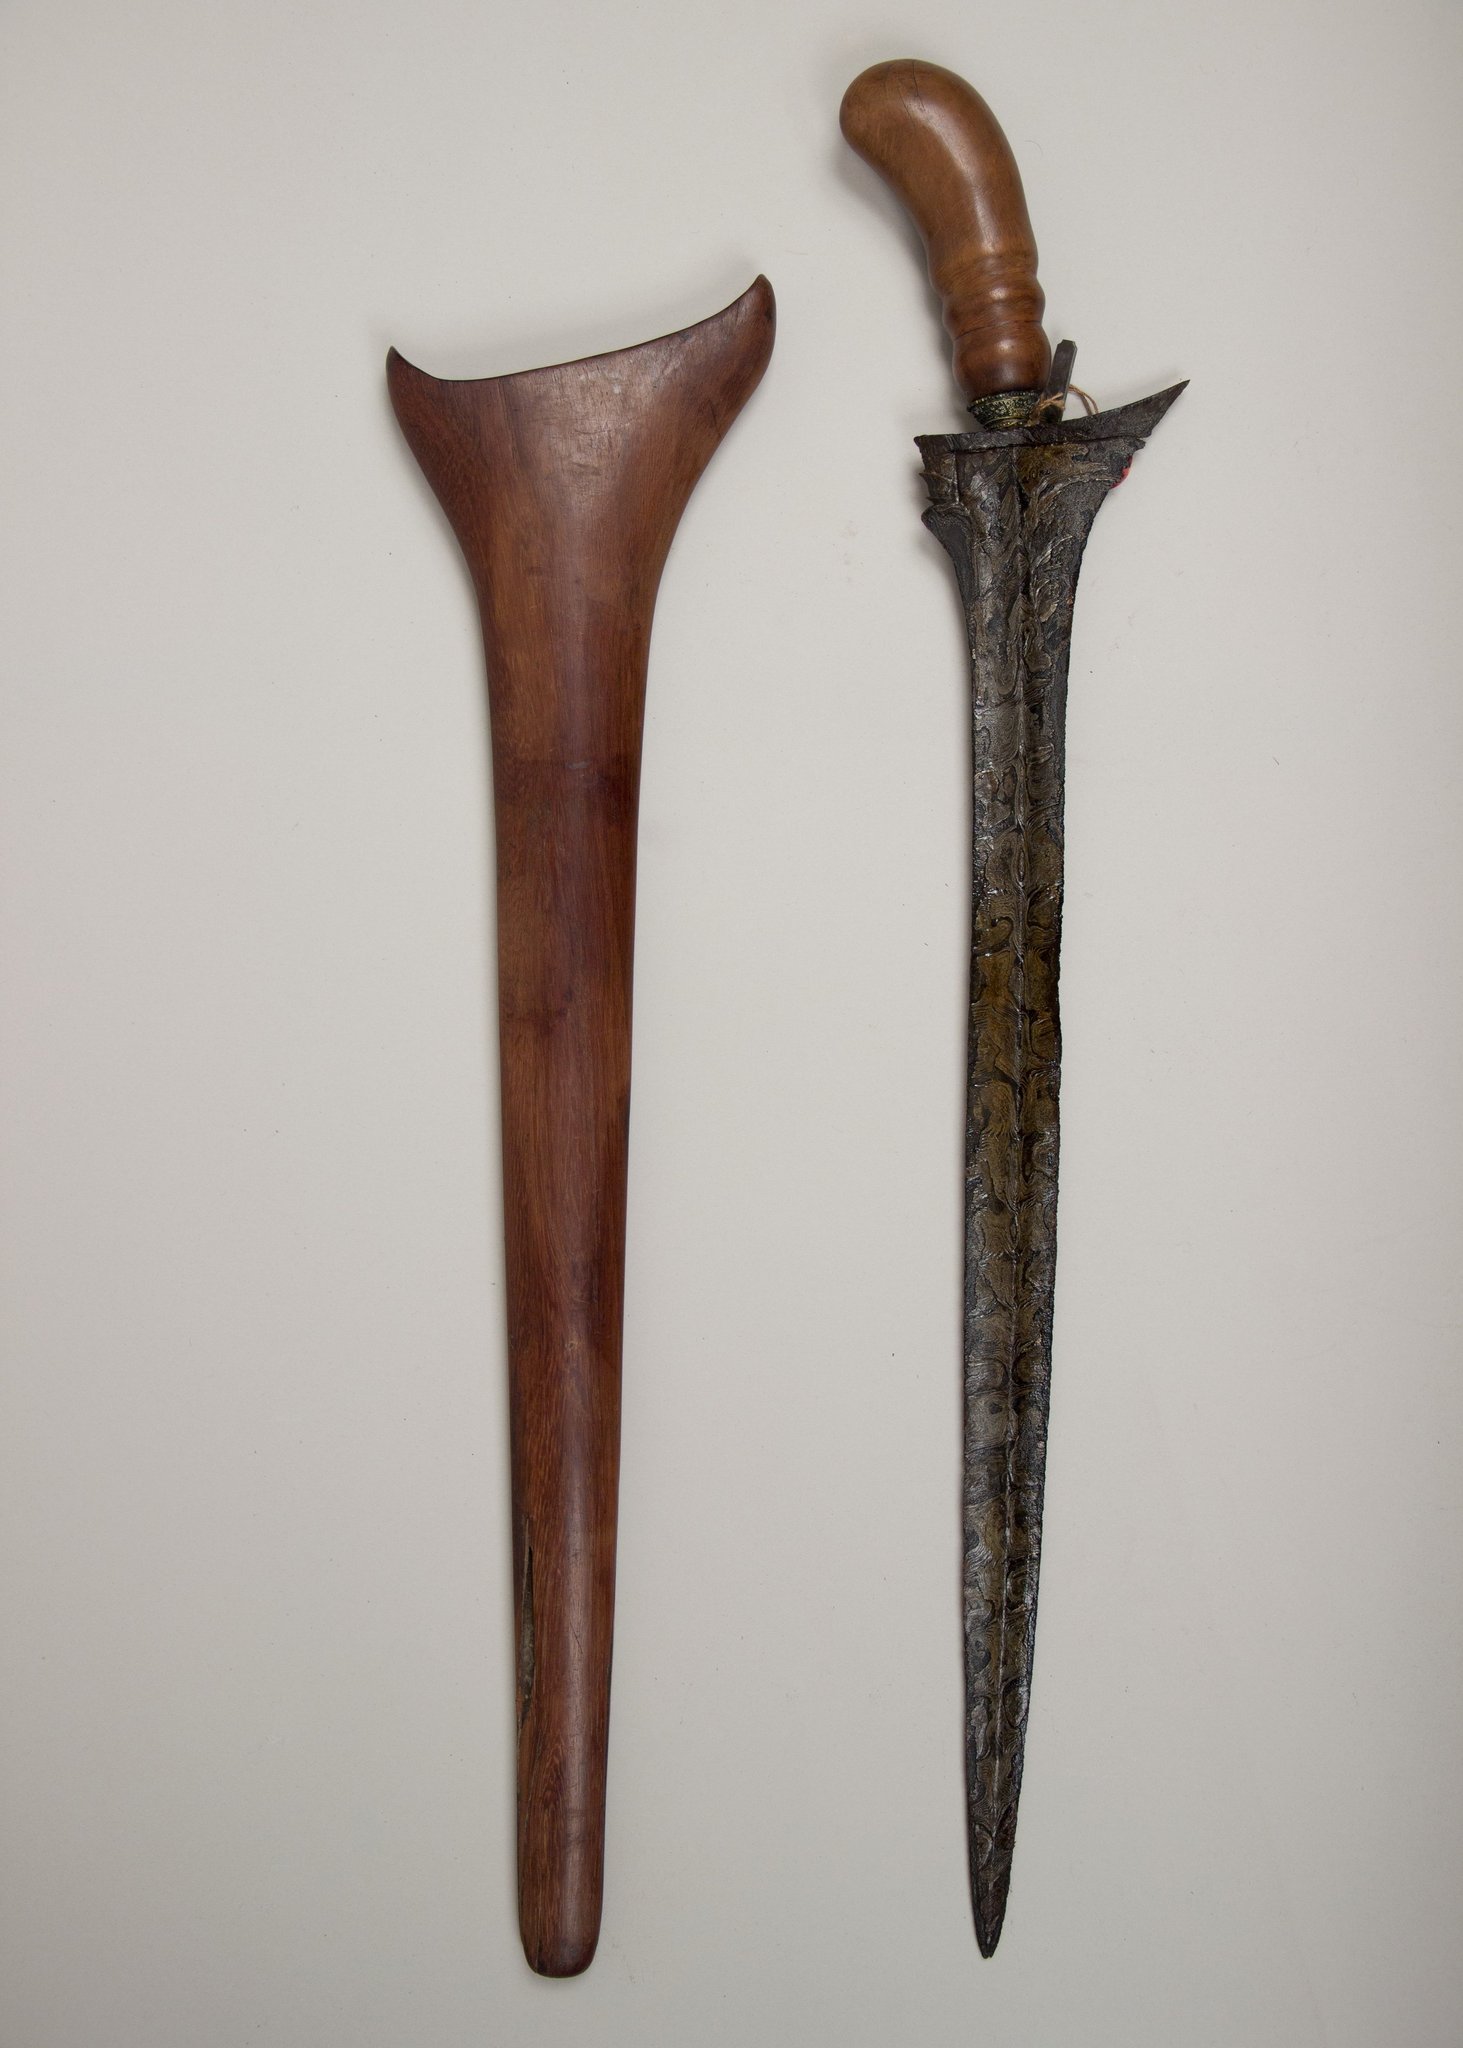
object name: kris with sheath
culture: javanese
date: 1501-1900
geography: indonesia